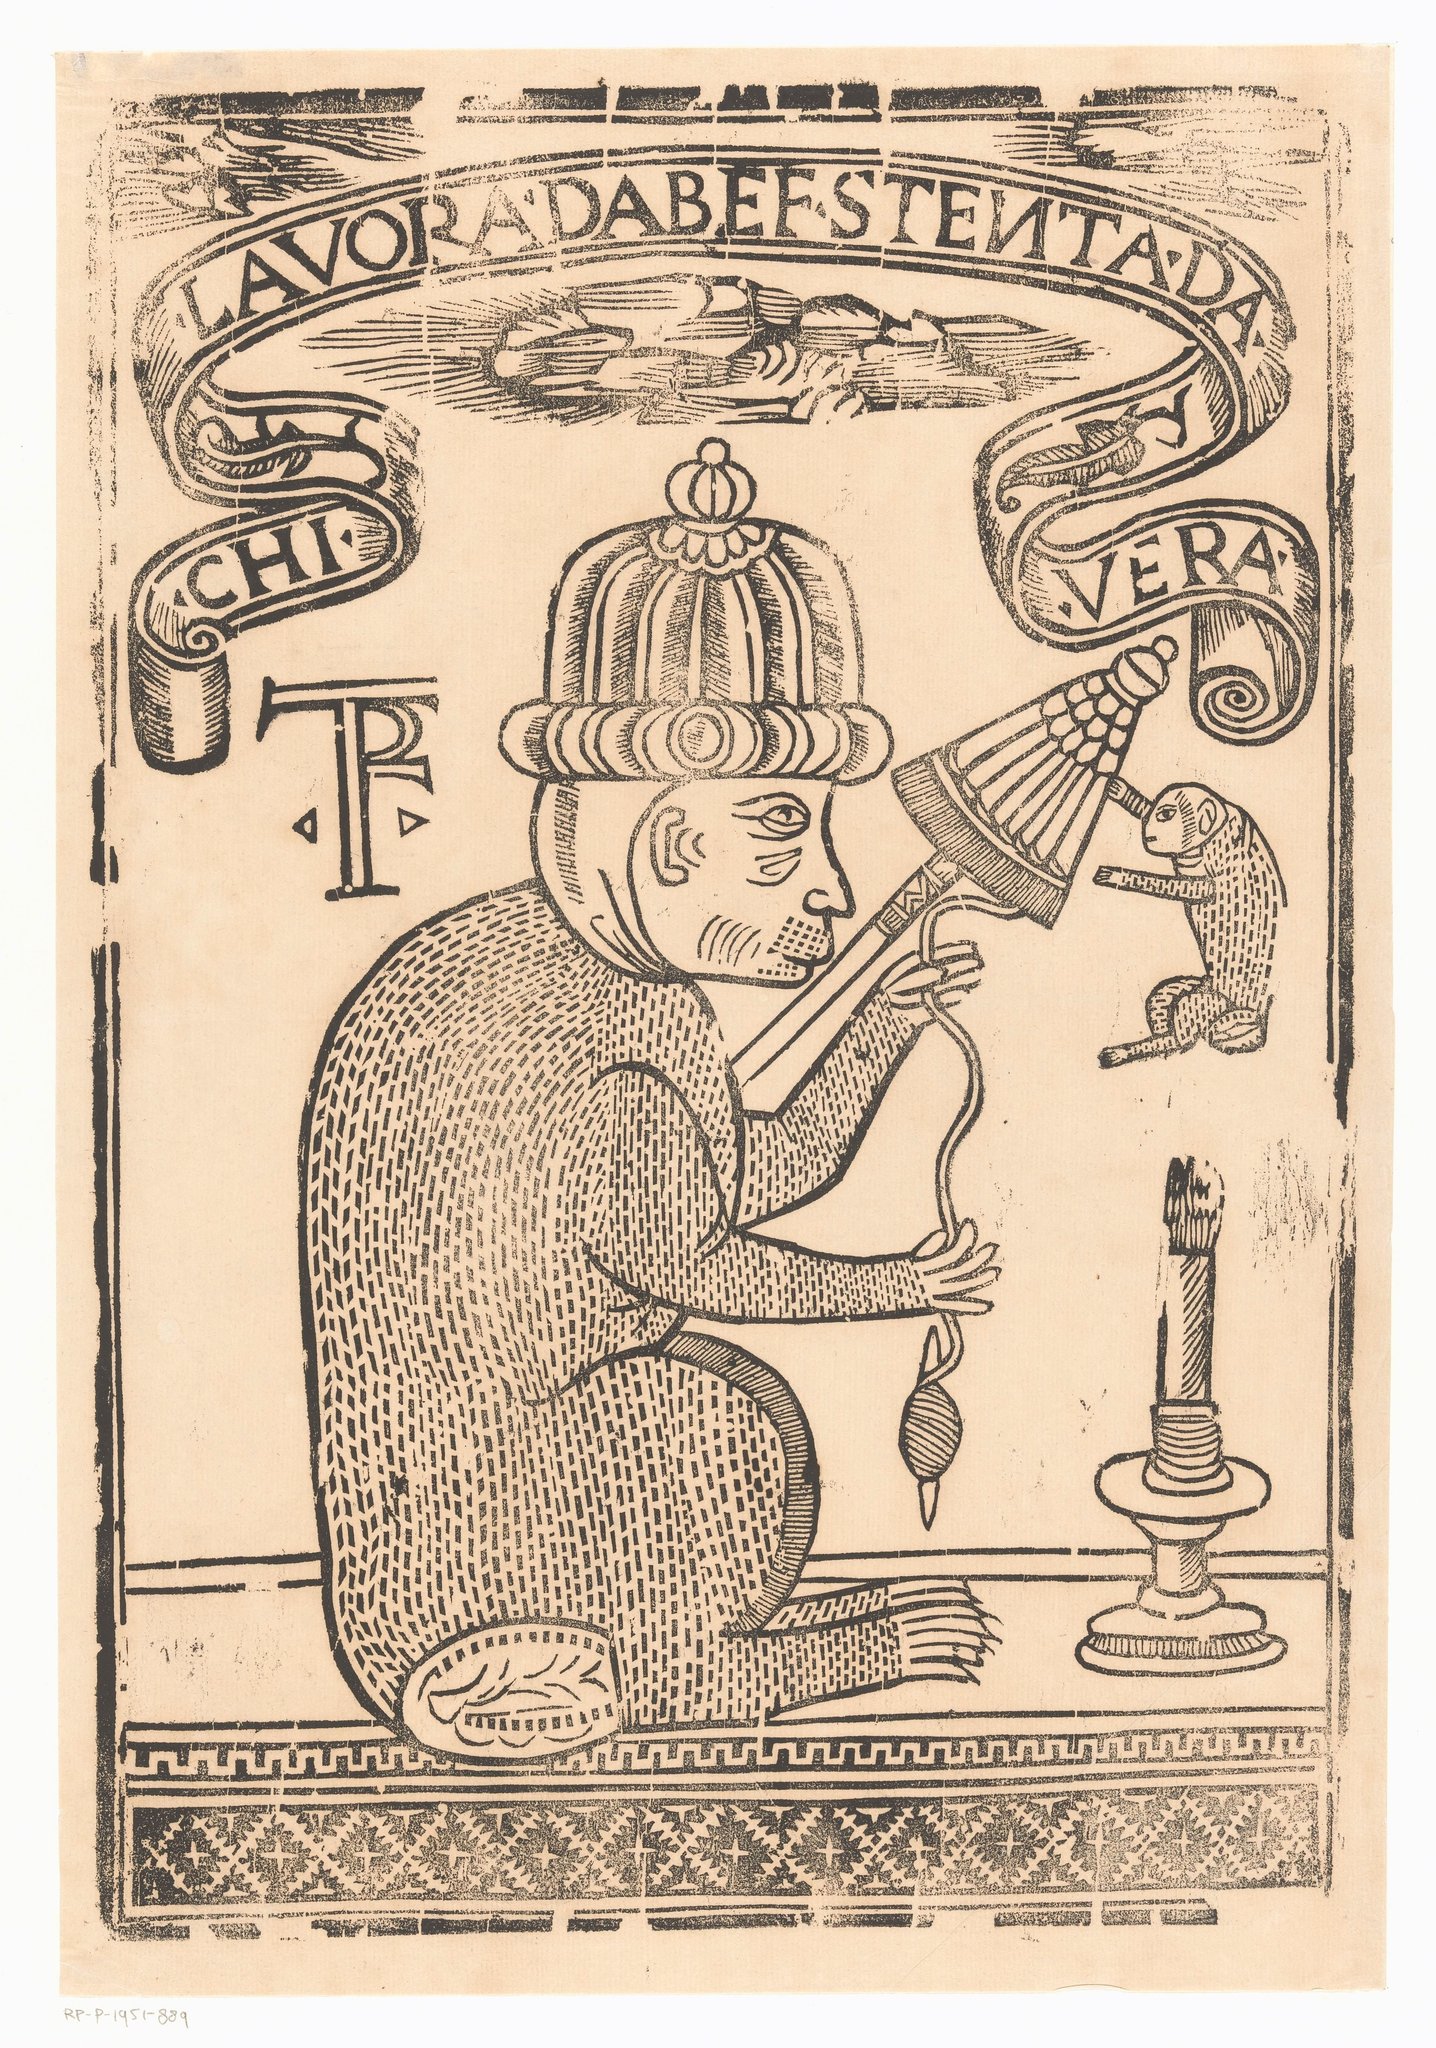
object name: print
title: Aap met spinrokken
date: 1400-1599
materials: paper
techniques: woodcut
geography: modena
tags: monkeys, apes, distaff, spinning (manufacture of yarn)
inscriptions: collector's mark: Lugt 2228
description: Een zittende aap met hoofddeksel en een spinrokken.